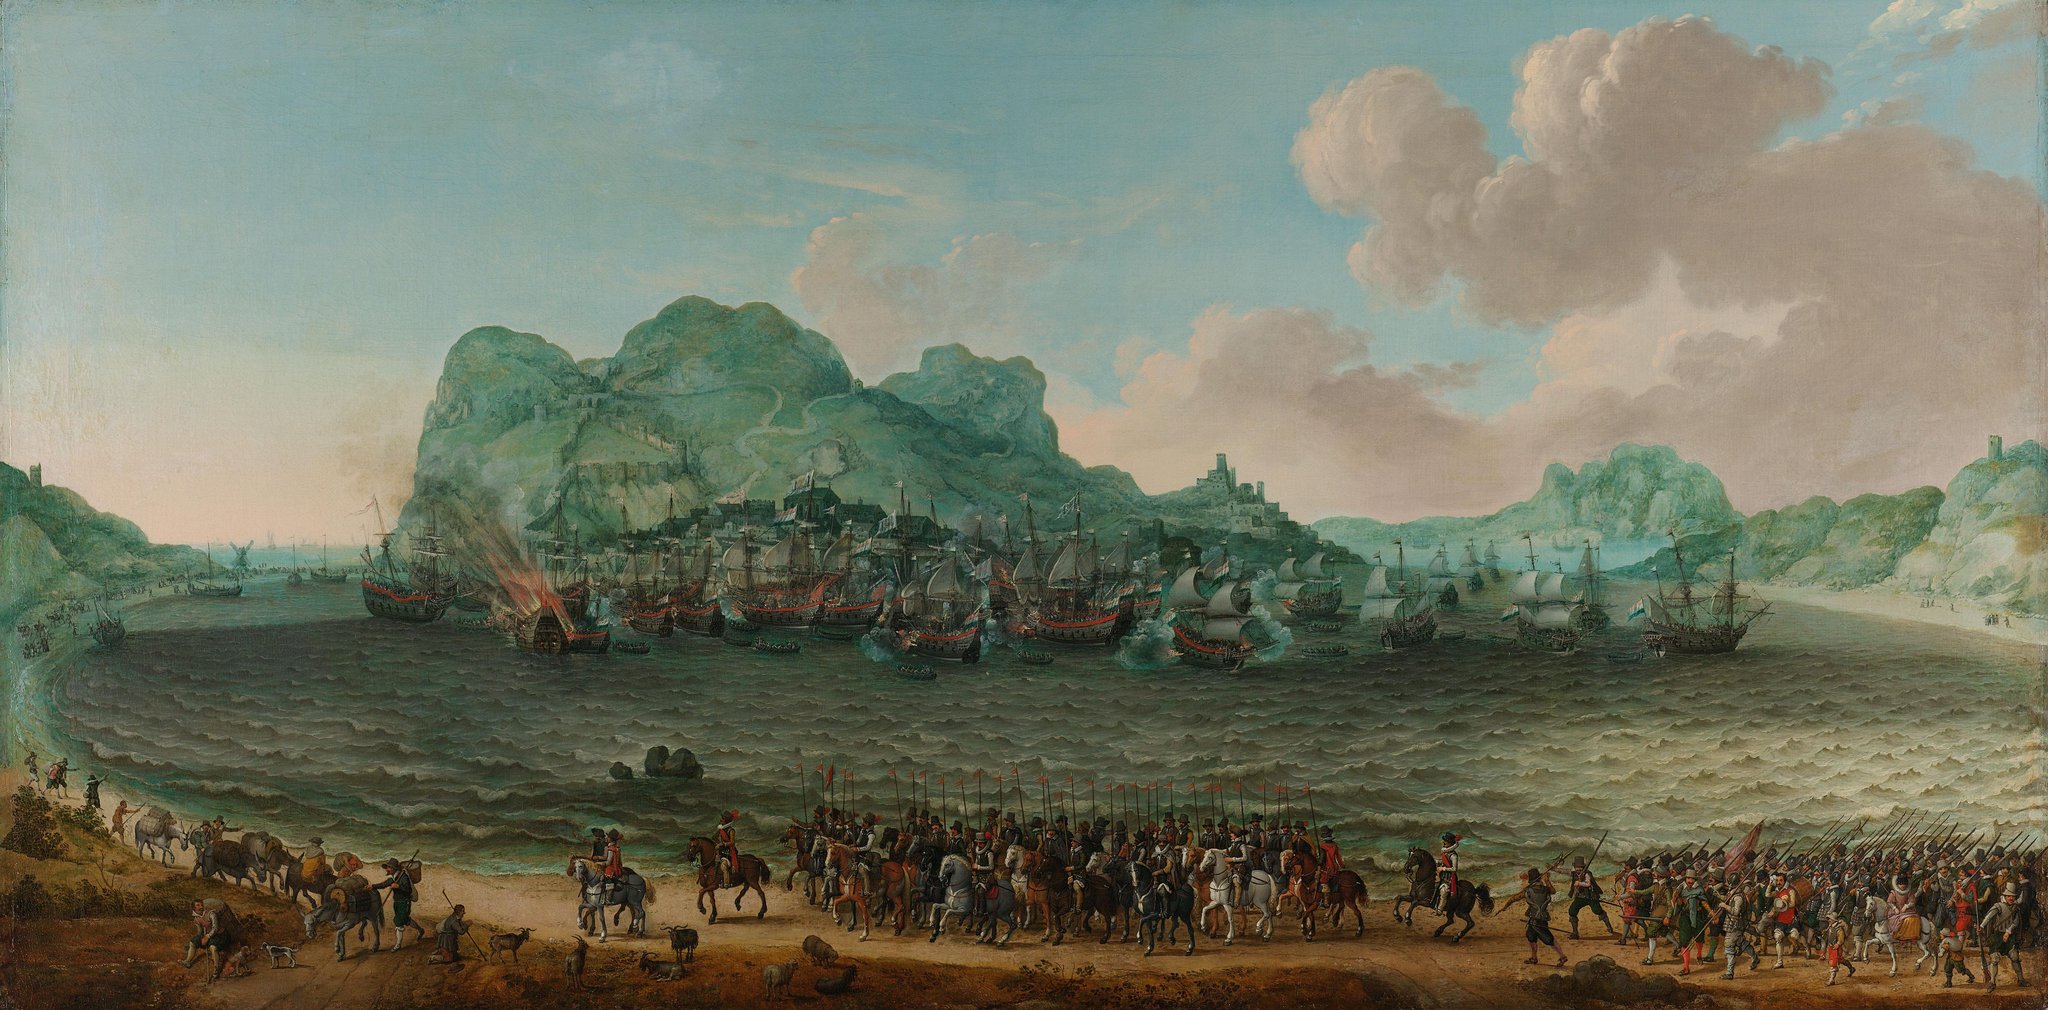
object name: painting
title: Victory over the Spanish near Gibraltar by a Fleet Commanded by Admiral Jacob van Heemskerck, 25 April 1607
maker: adam willaerts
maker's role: painter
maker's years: 1577-1664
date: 1617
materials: canvas, oil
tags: amsterdam, jacob van heemskerck, army 'en route', sailing-ship, sailing-boat, rocky coast, battle (+ sailing-ships)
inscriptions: signature and date, bottom right (A and D ligated): ‘AD. Willarts 1617’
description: De overwinning op de Spanjaarden bij Gibraltar door een vloot onder bevel van Jacob van Heemskerck, 25 april 1607. In de verte woedt de zeeslag bij de rots van Gibraltar. Over het strand op de voorgrond marcheren een divisie cavalerie en een divisie infanterie.